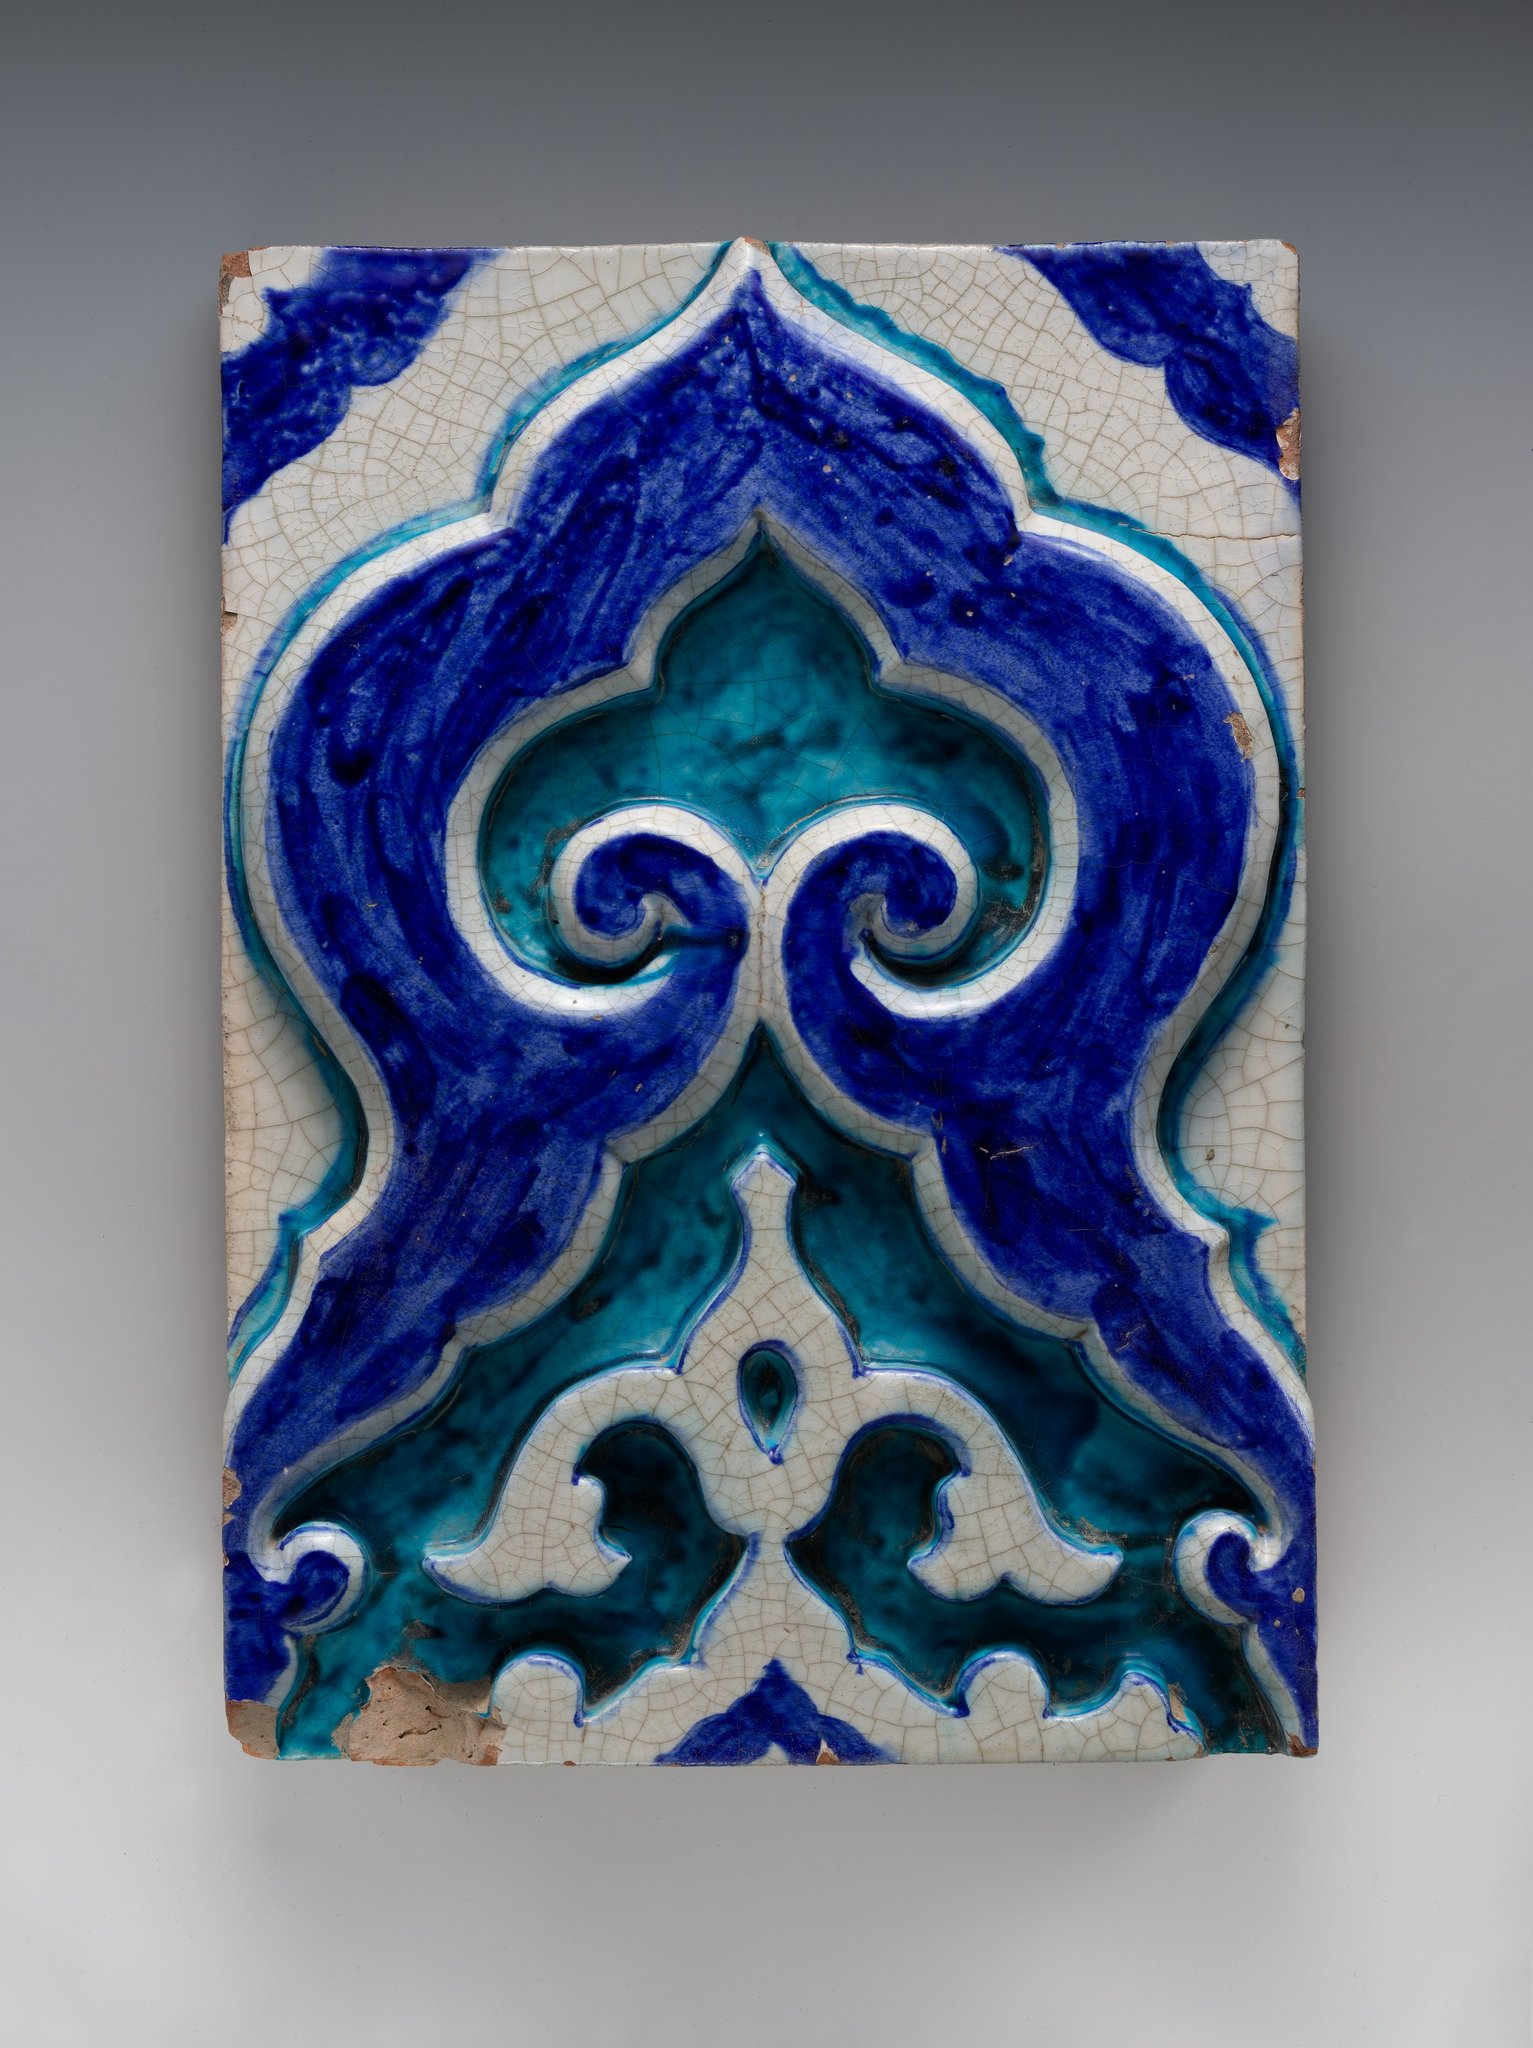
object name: tile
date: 1701-1800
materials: earthenware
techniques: glazing, molding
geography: pakistan